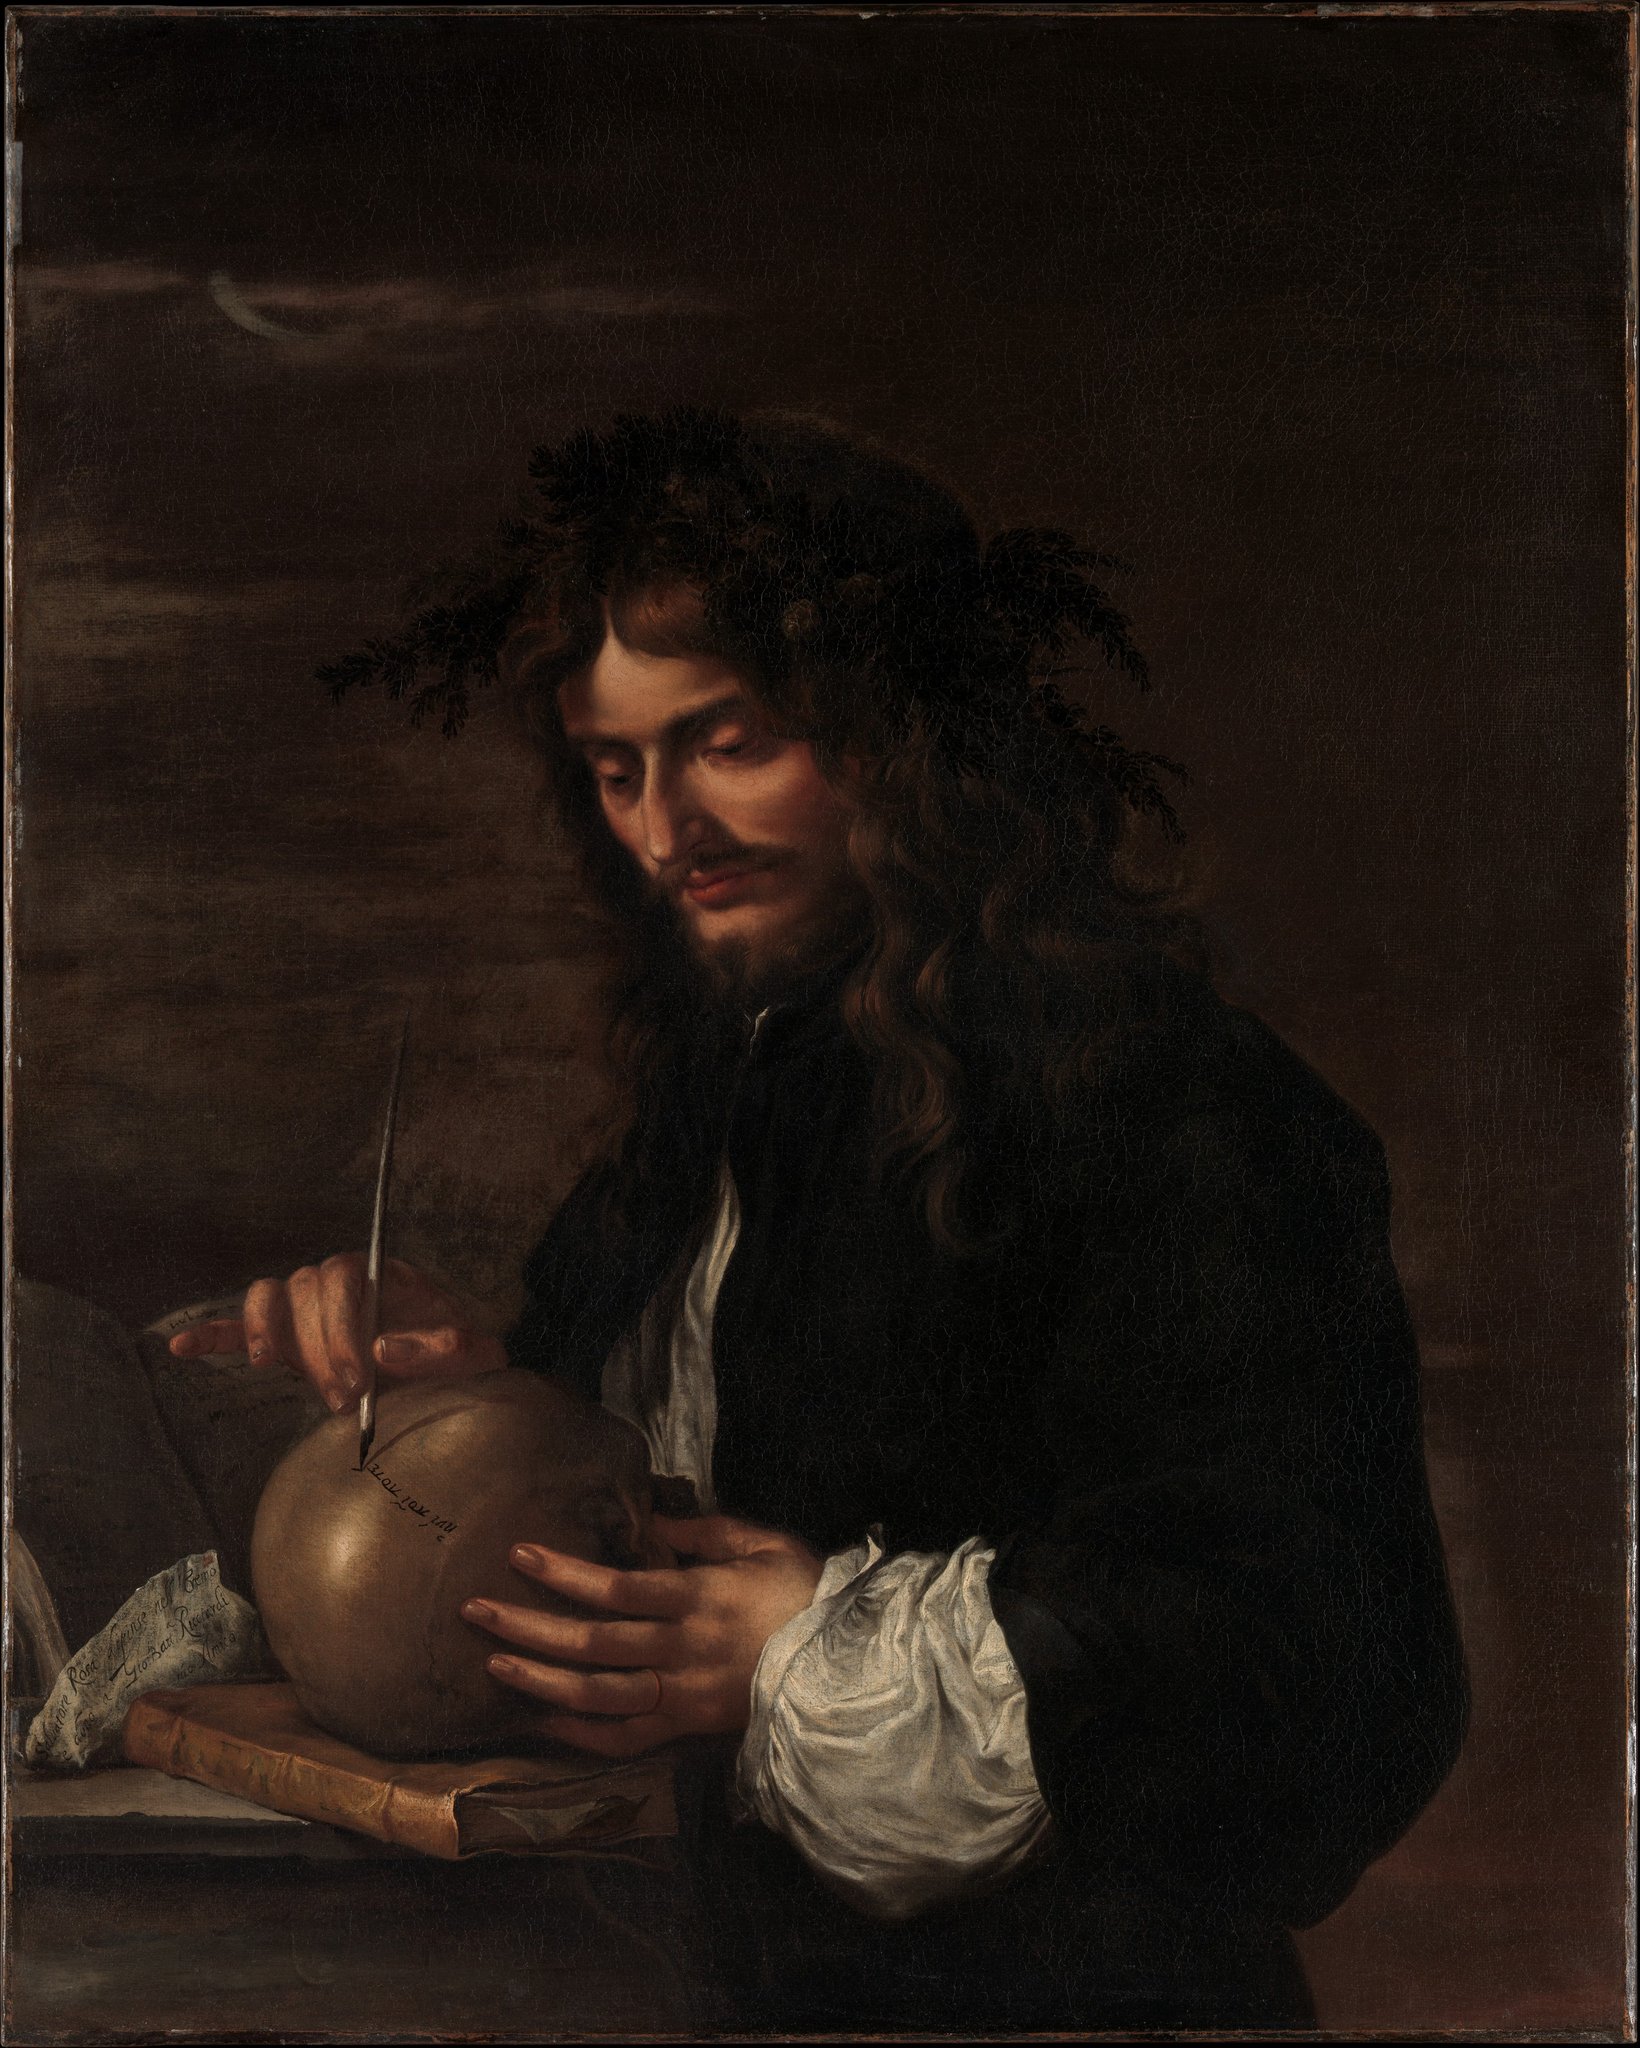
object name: painting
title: Self-Portrait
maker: salvator rosa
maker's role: artist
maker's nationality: italian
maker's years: 1615-1673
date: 1647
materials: canvas, oil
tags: skulls,men,self-portraits,writing